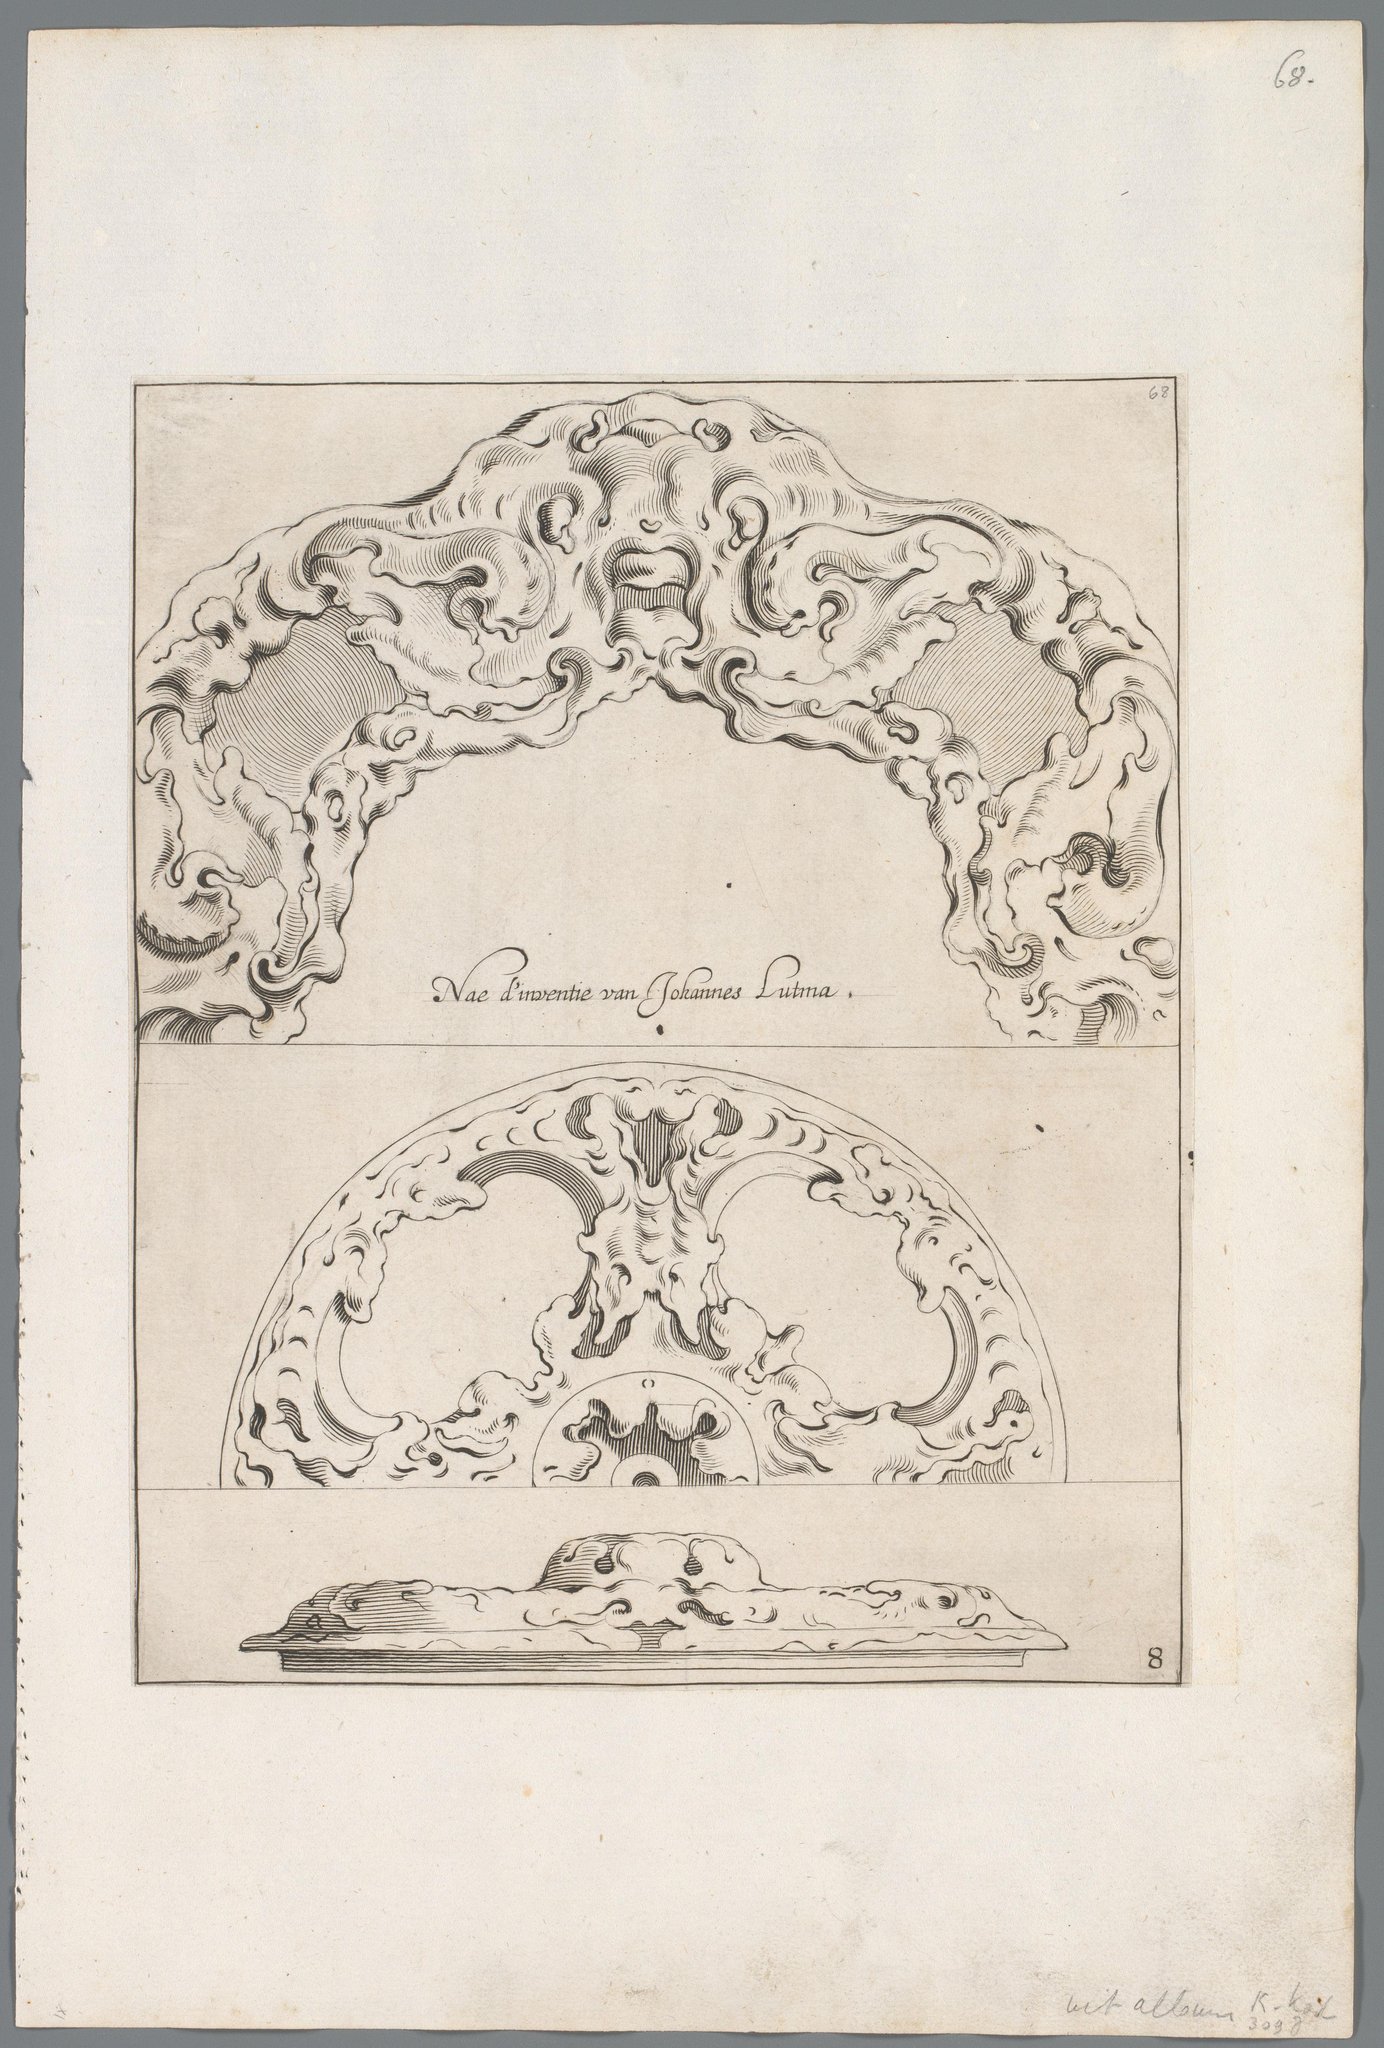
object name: print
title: Verscheijde constige vindingen om in gout, silver, hout en steen te wercken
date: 1651-1653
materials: paper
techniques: engraving, etching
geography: amsterdam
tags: dish, plate, saucer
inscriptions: collector's mark: Lugt 2760, collector's mark: Lugt 2228